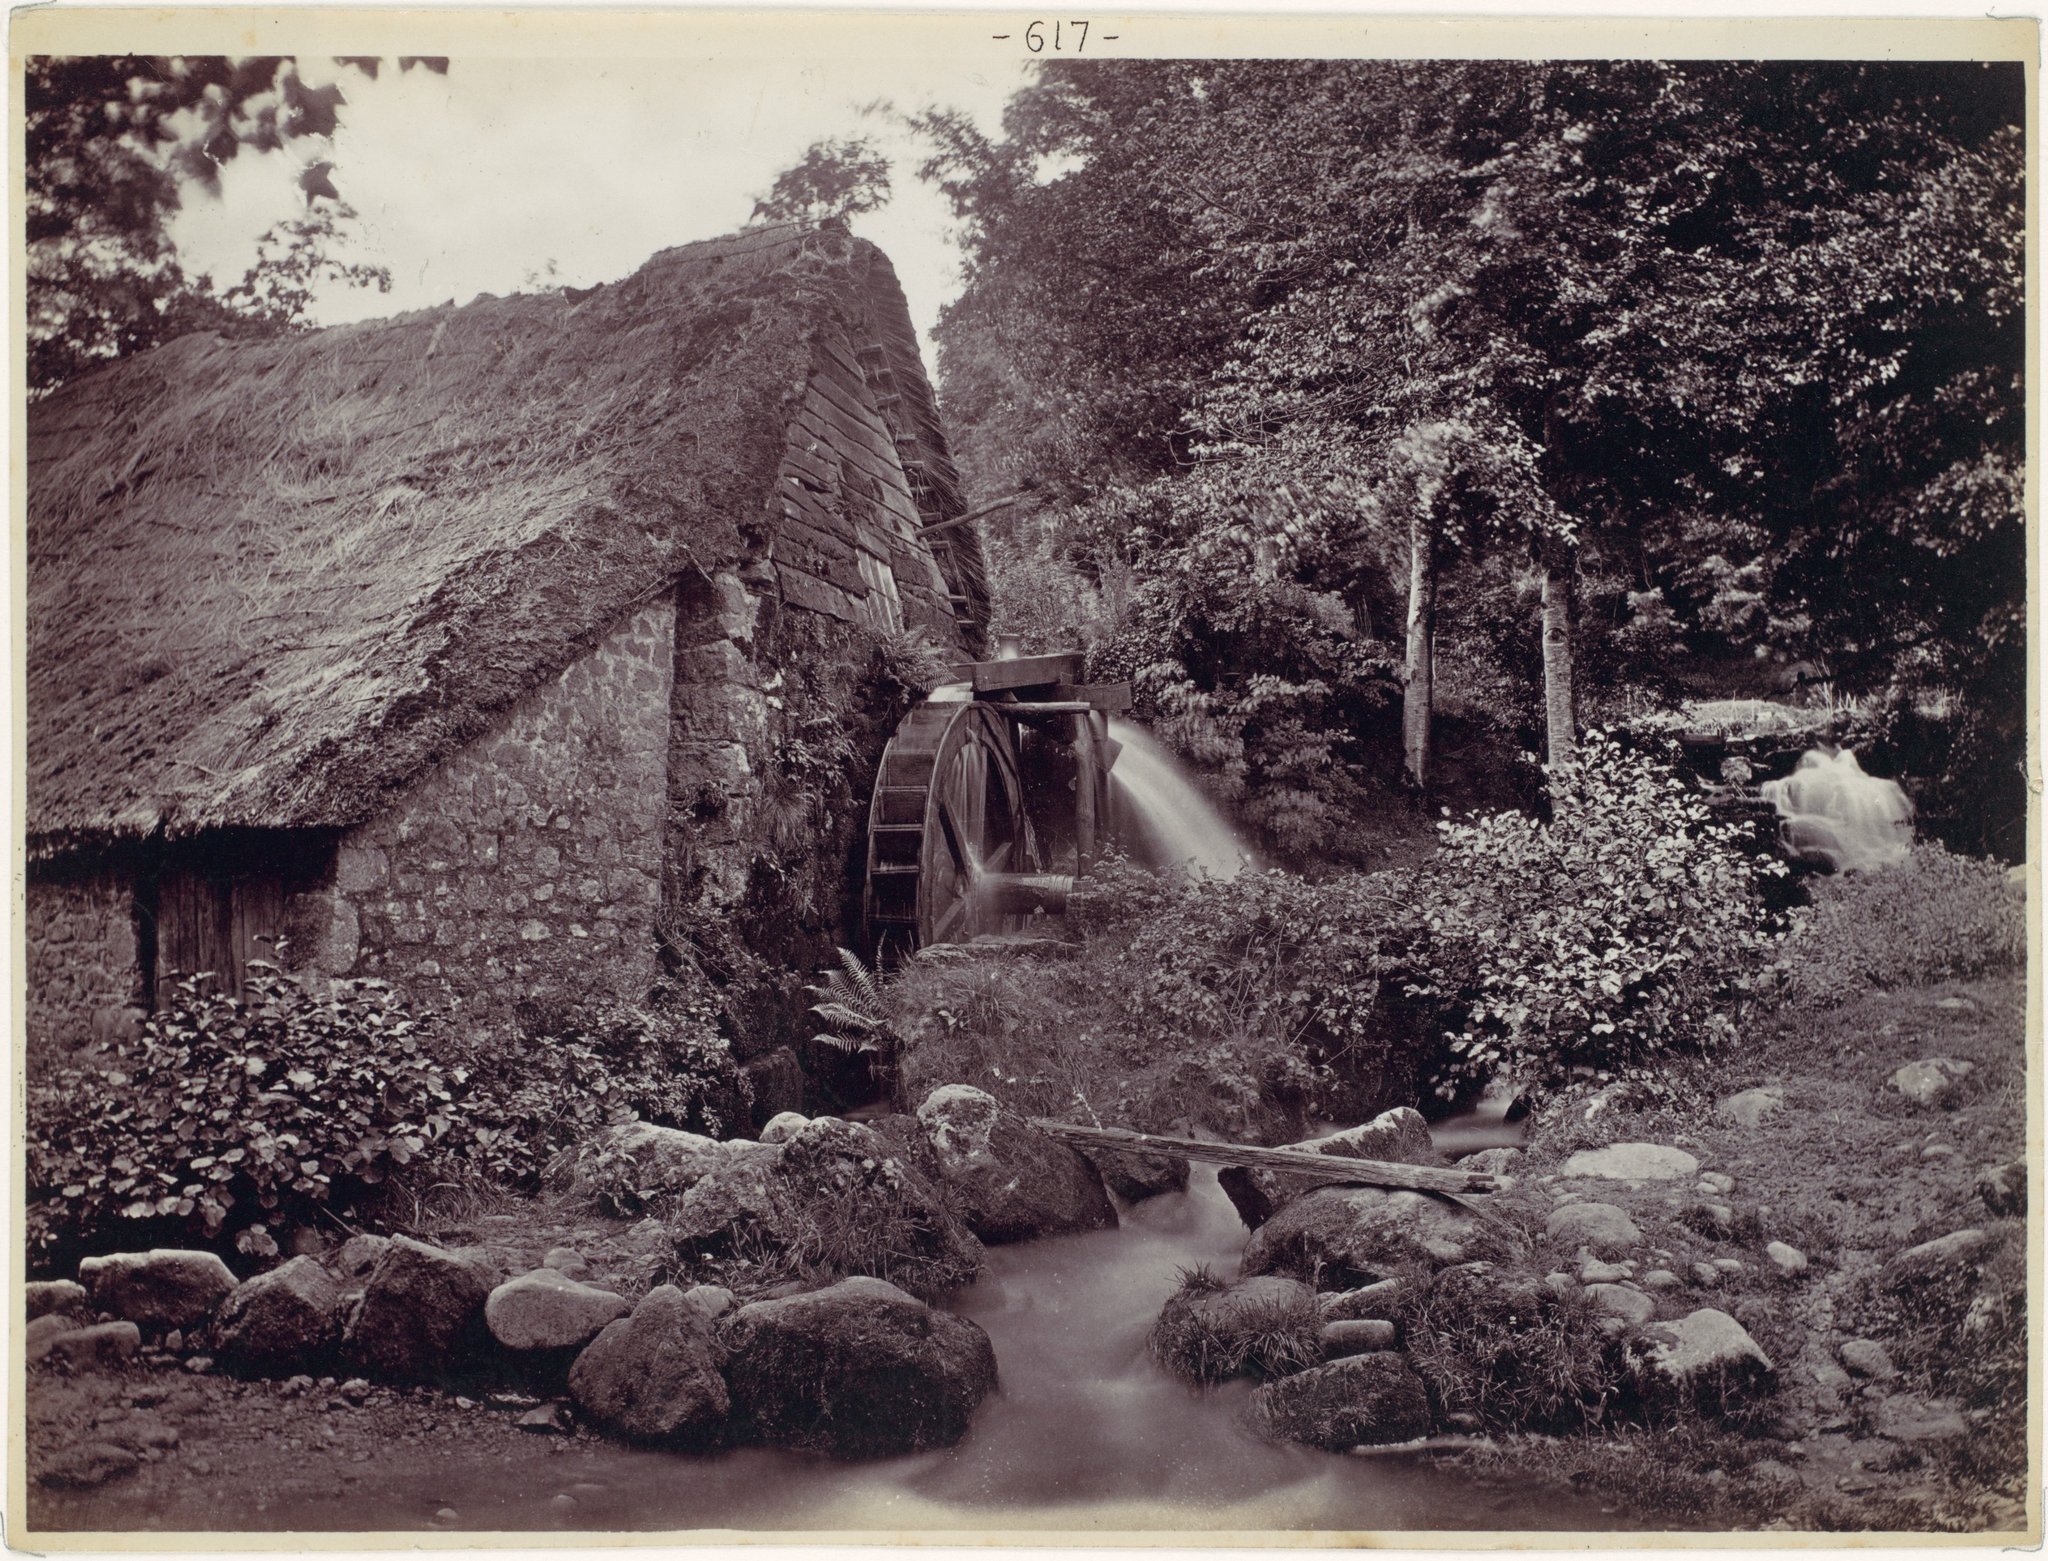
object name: photograph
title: Chargford, Holy S. Mill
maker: francis bedford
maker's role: artist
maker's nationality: british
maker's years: 1816-1894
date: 1870-1879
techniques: albumen silver print, glass negative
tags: watermills,landscapes